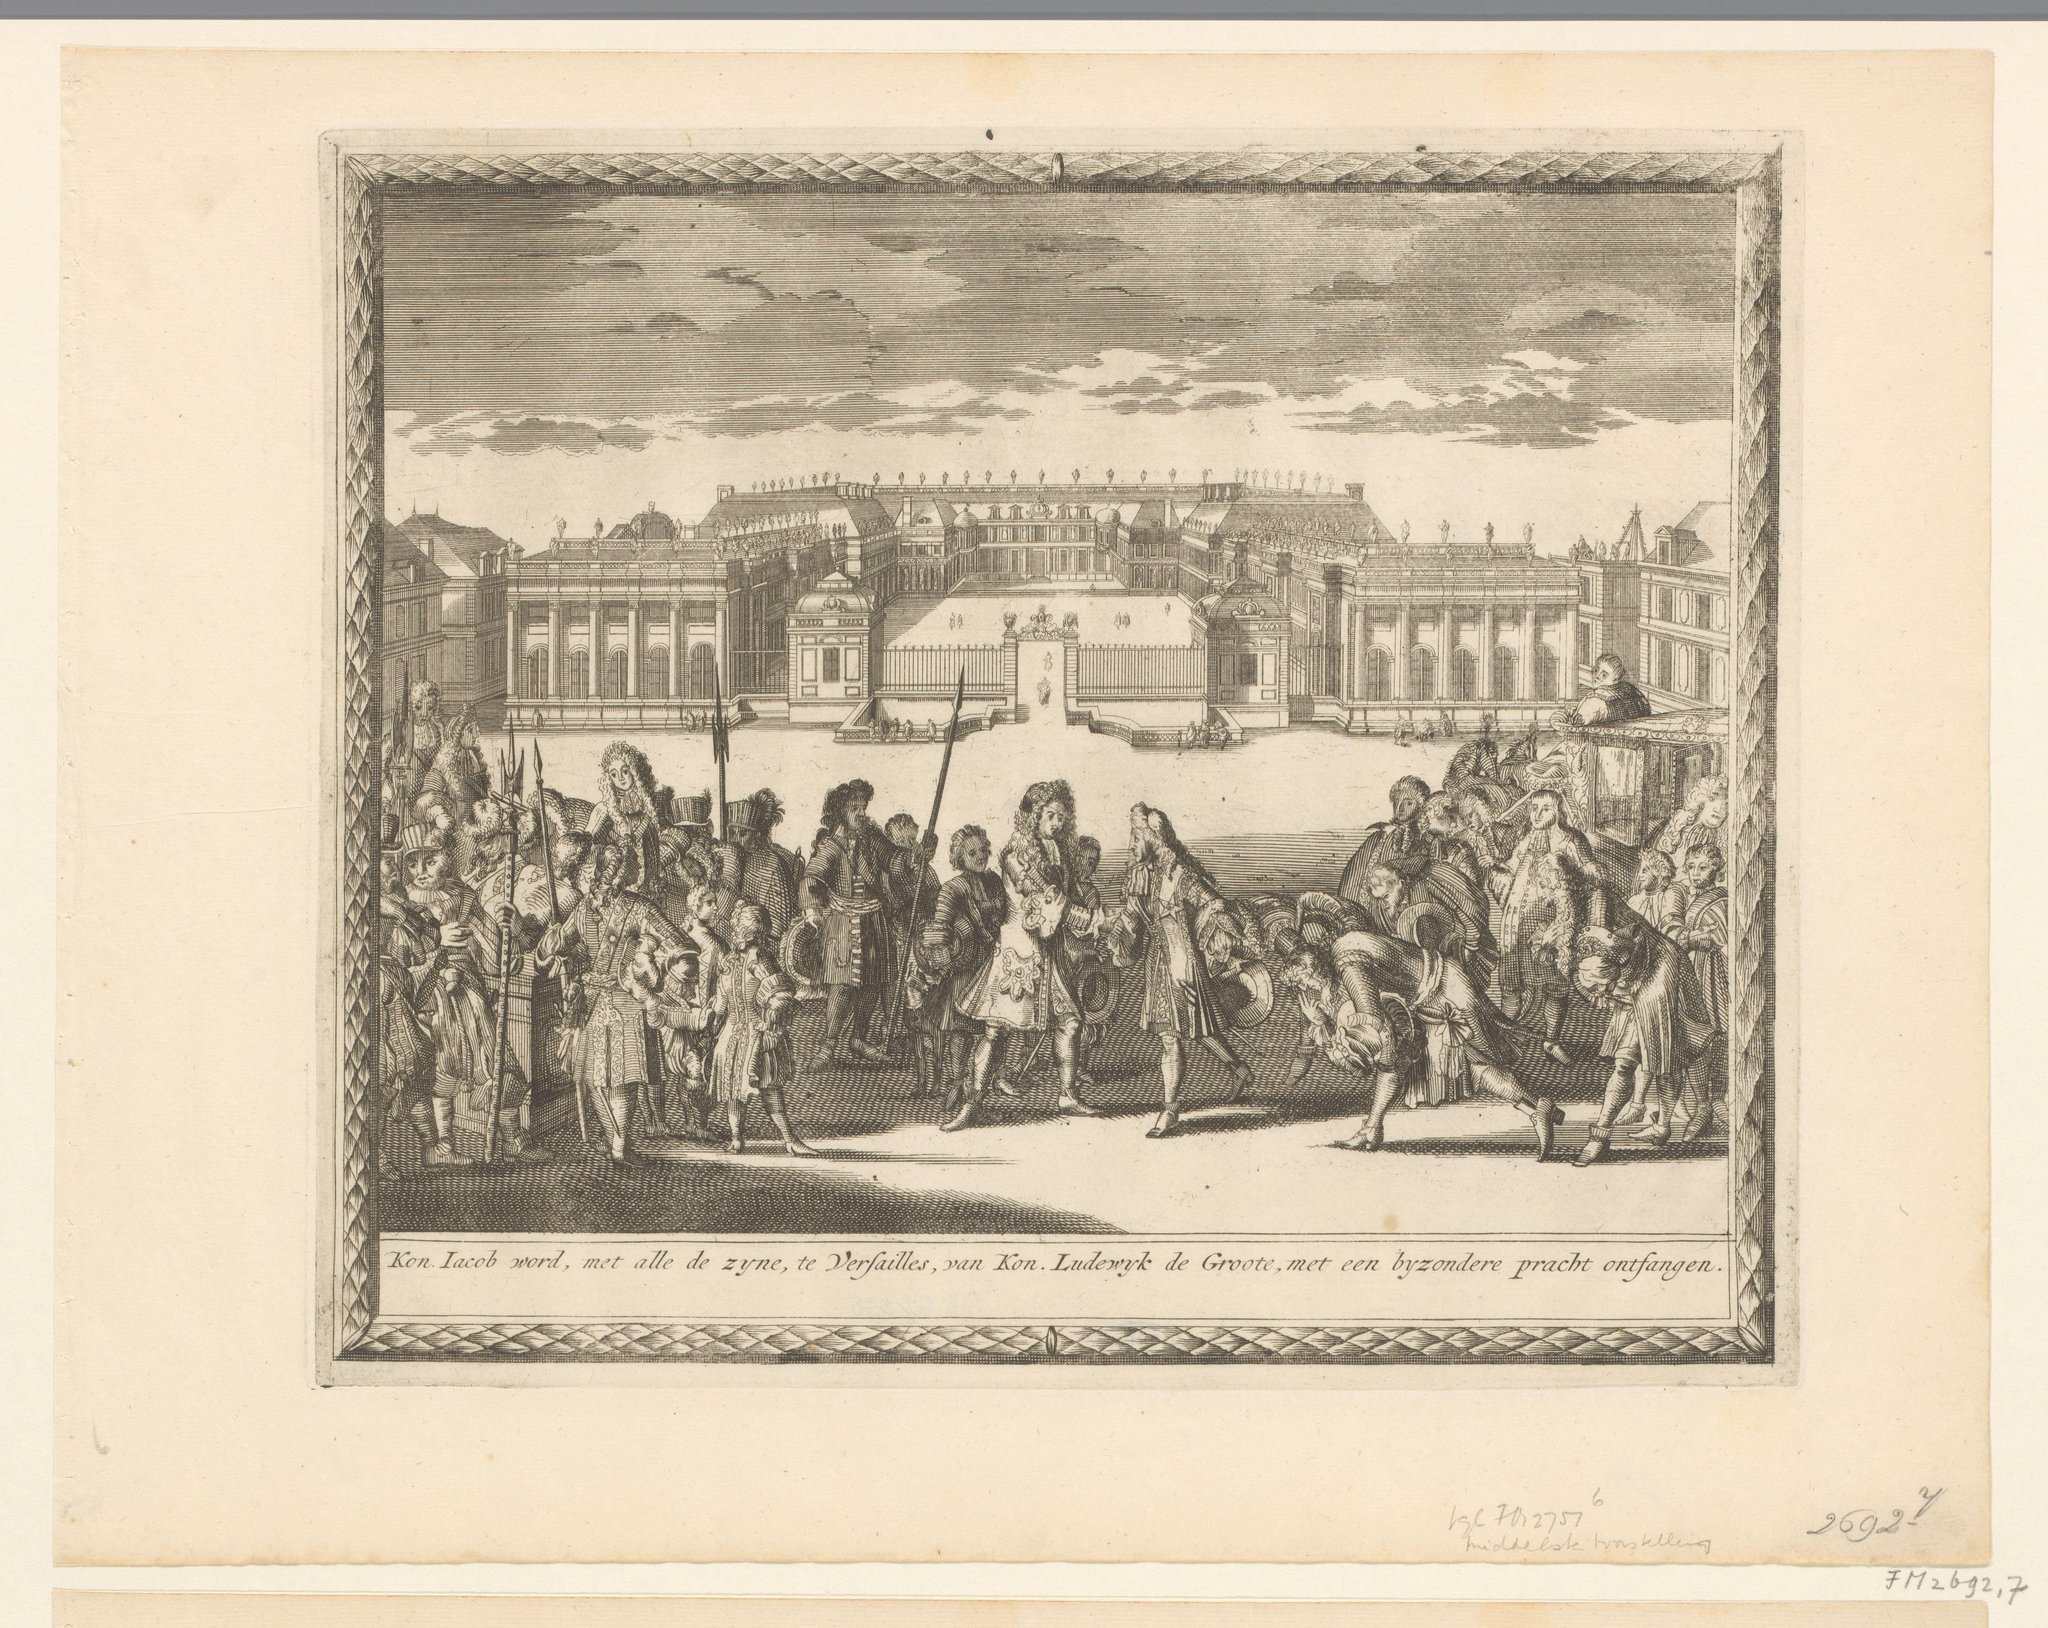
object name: album leaf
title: Geschiedenis van de omwenteling in Engeland 1688-1691 in 20 platen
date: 1691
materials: paper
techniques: etching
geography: northern netherlands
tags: jacobus ii (koning van engeland en schotland), lodewijk xiv (koning van frankrijk), being welcomed ~ travelling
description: Ontvangst van koning Jacobus II met zijn gevolg te Versailles door koning Lodewijk XIV, 6 januari 1689. Plaat 7 in een serie van 20 platen over de Glorious Revolution in Engeland in de jaren 1688-1691.